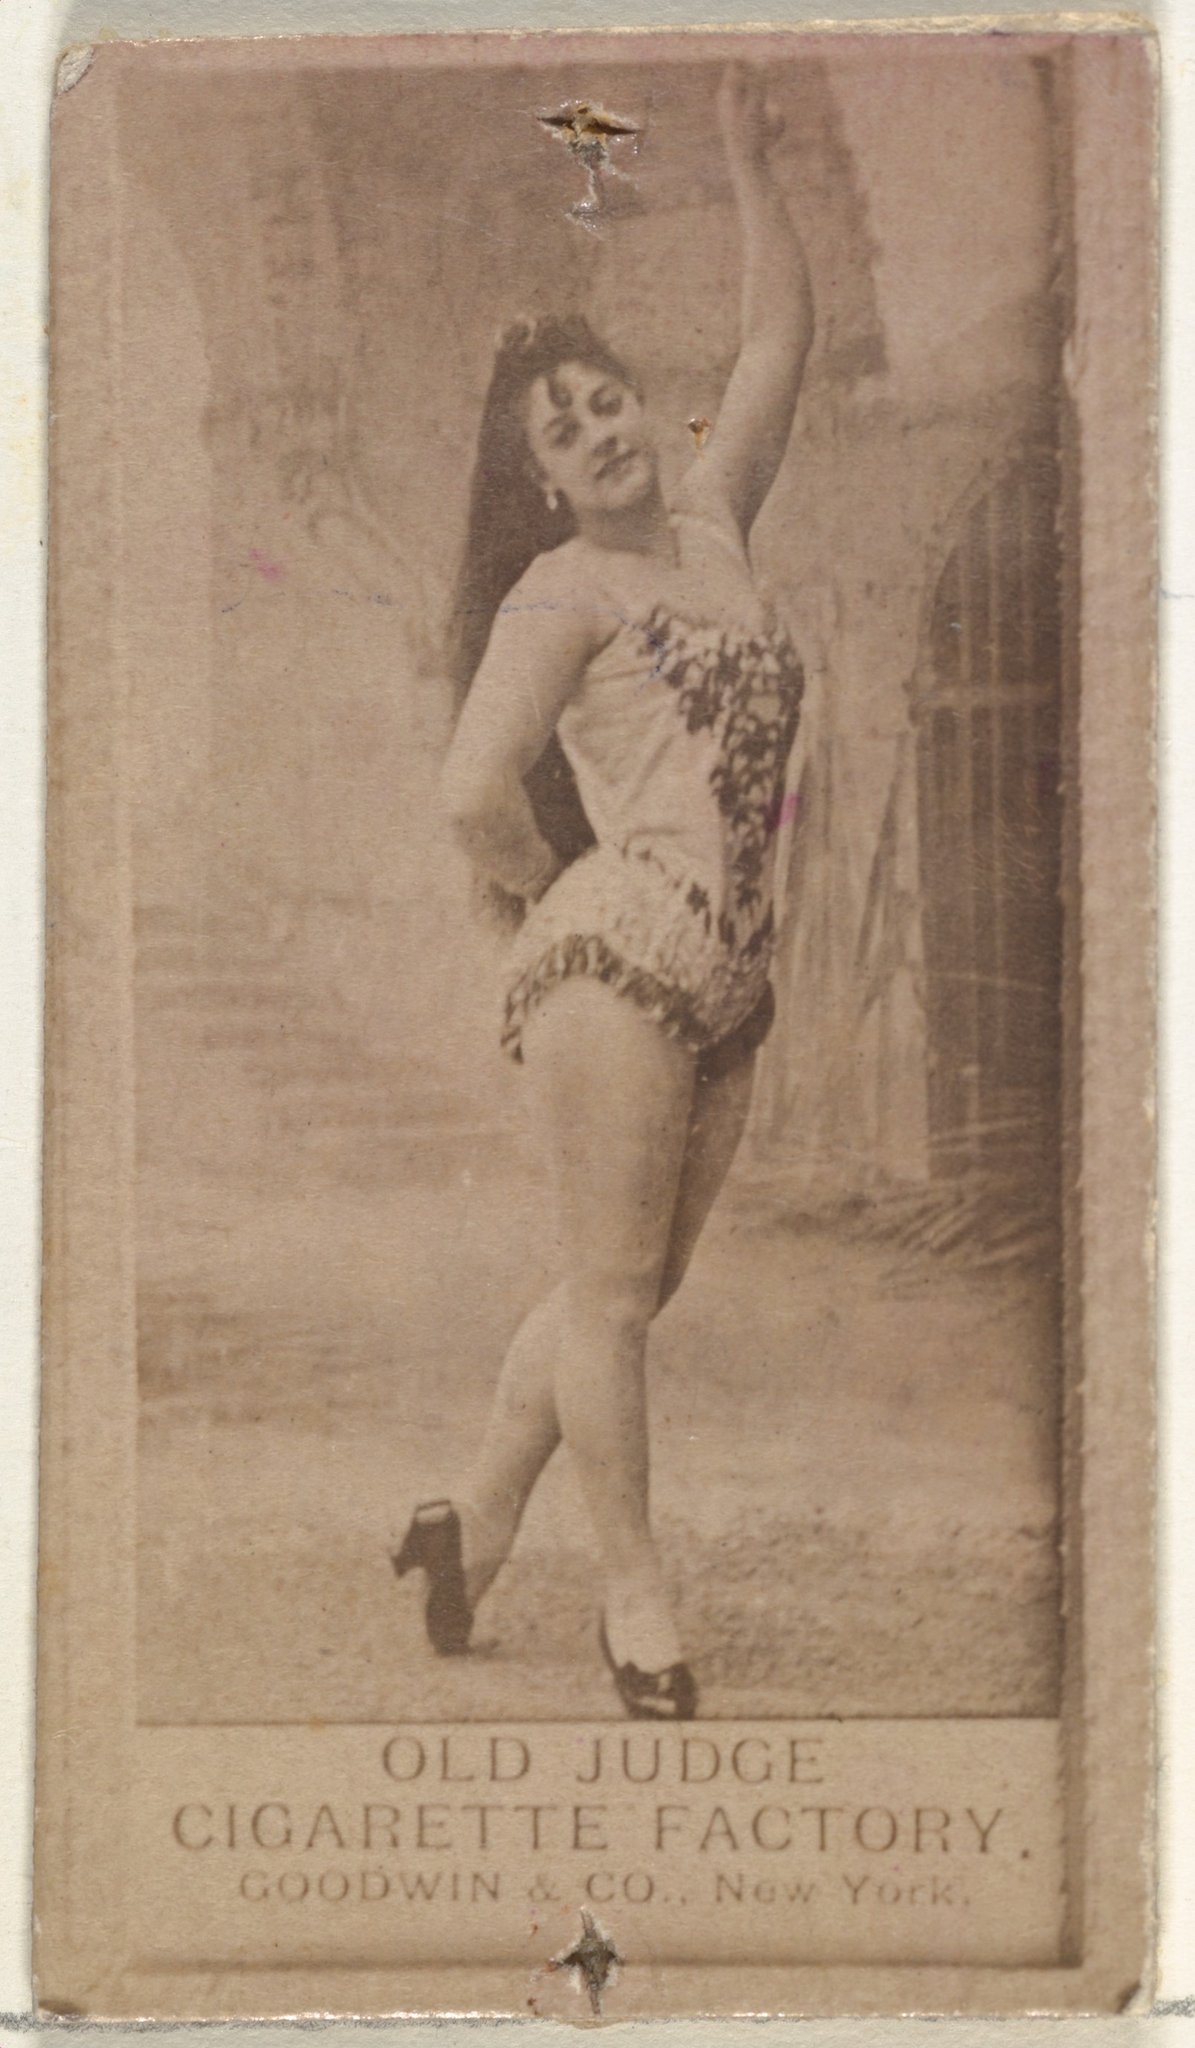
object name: photograph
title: From the Actors and Actresses series (N171) for Old Judge Cigarettes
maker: goodwin & company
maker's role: publisher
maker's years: 1850-1950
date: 1886-1890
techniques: albumen silver print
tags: portraits,women,actresses